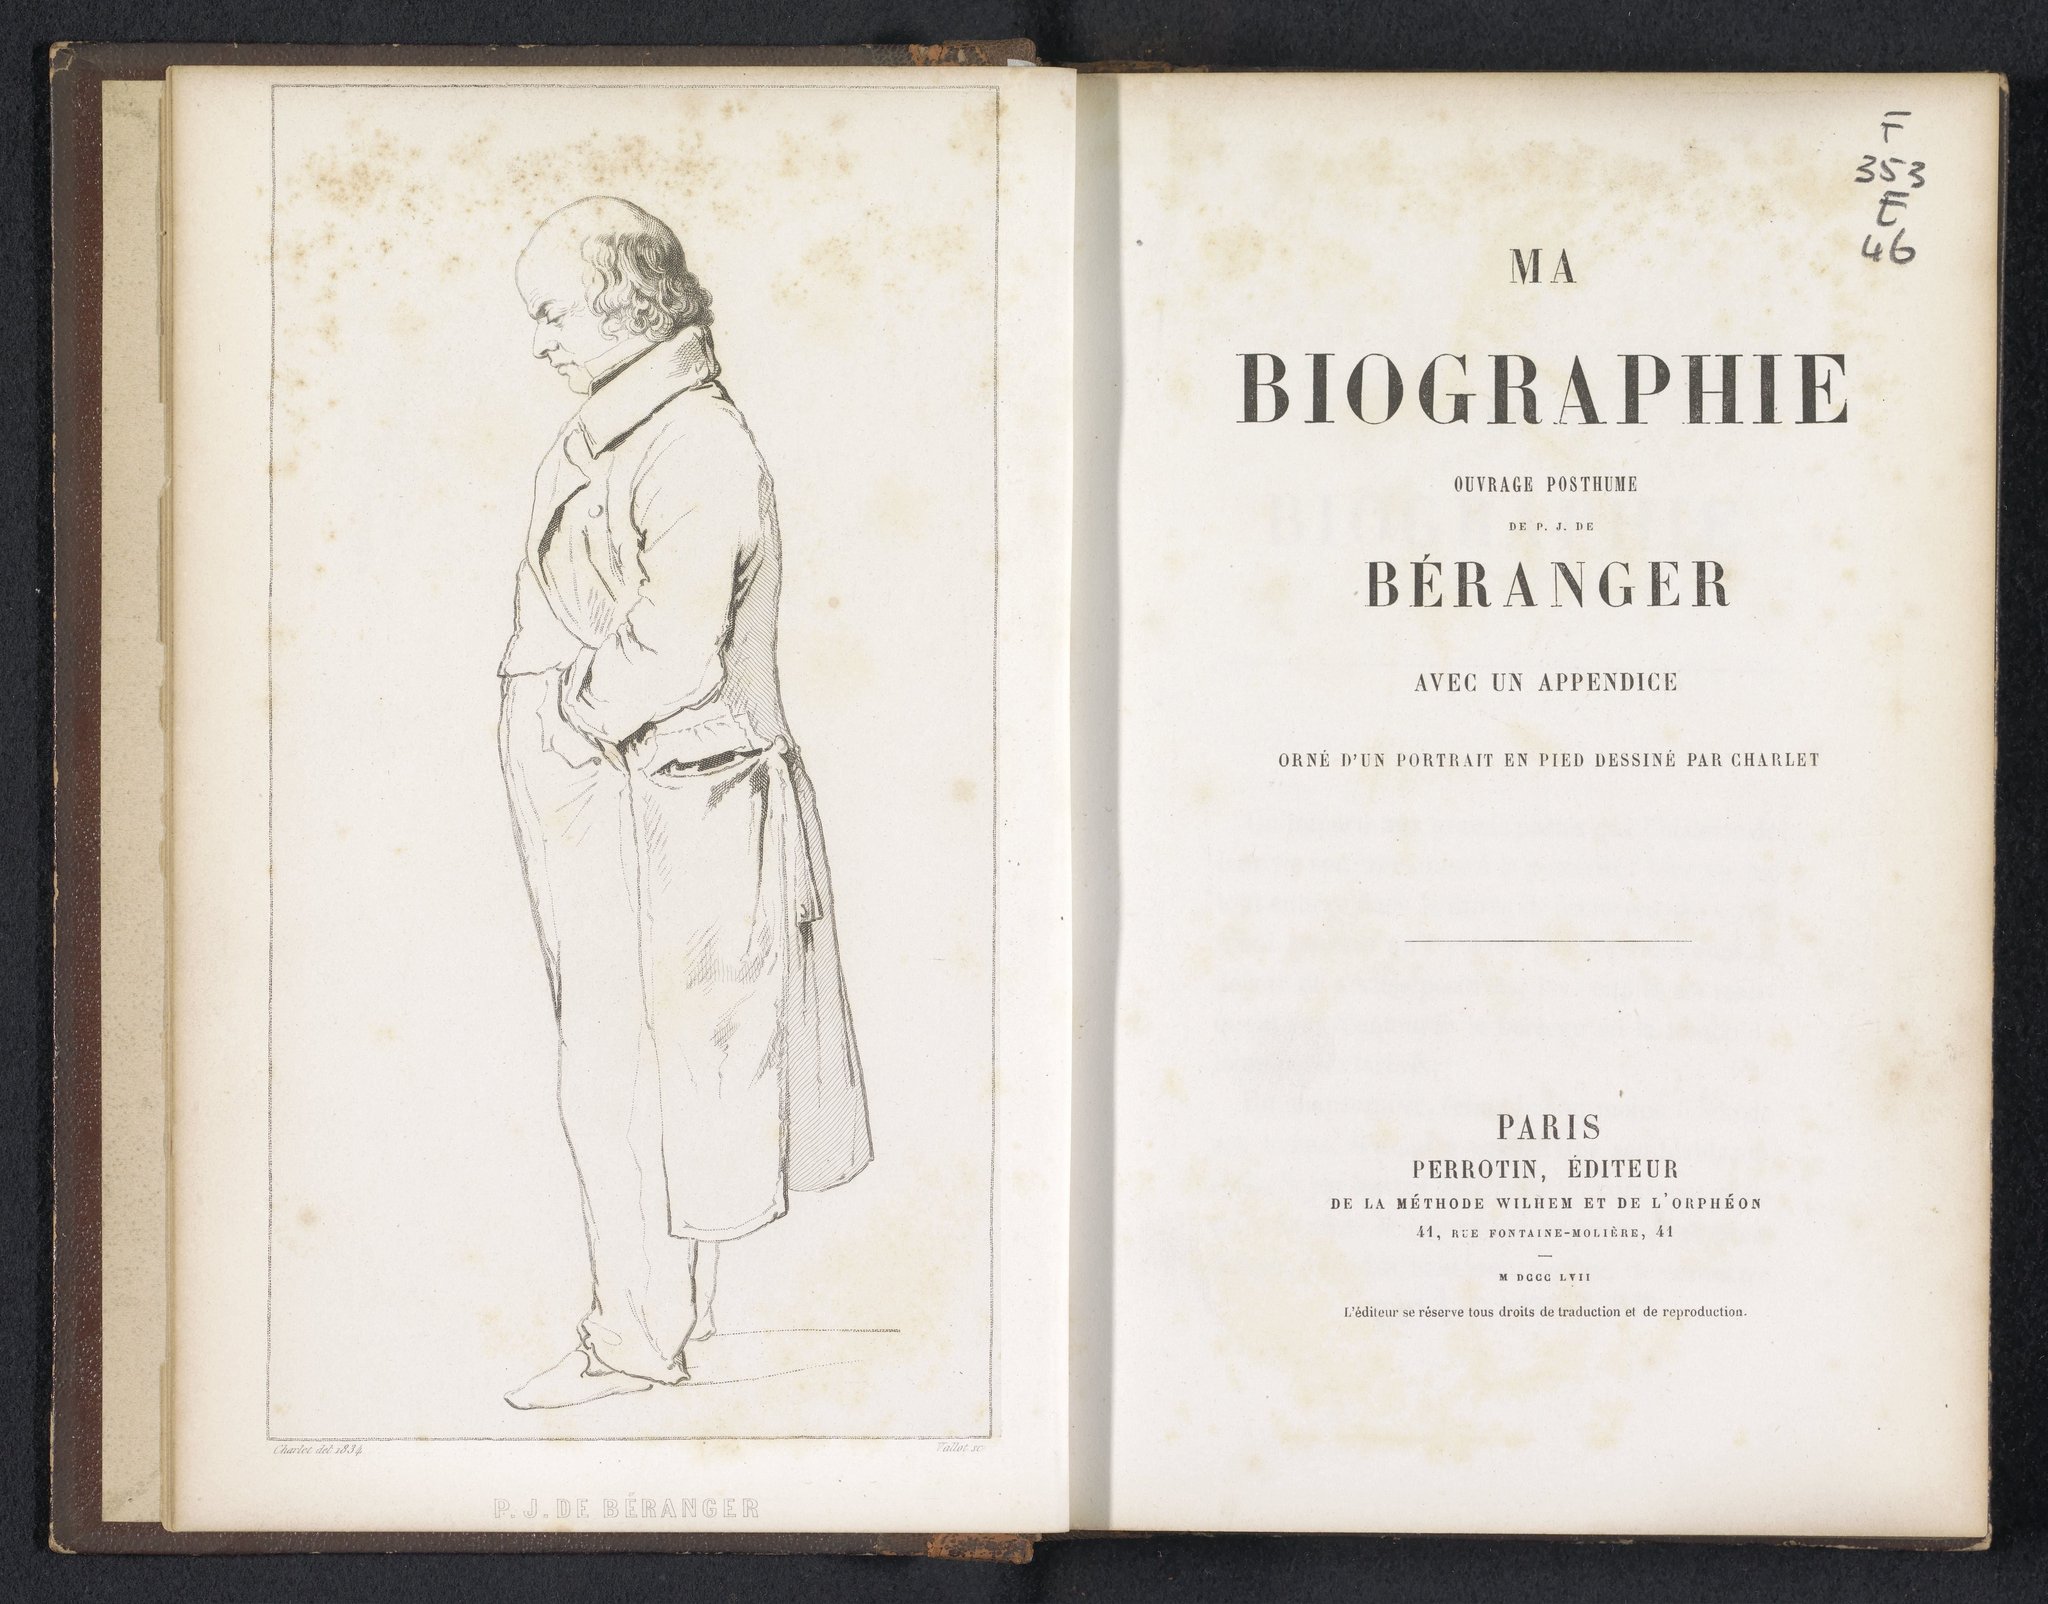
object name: book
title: Ma biographie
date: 1857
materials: leather, paper, photographic support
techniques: albumen print, engraving, printing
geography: paris